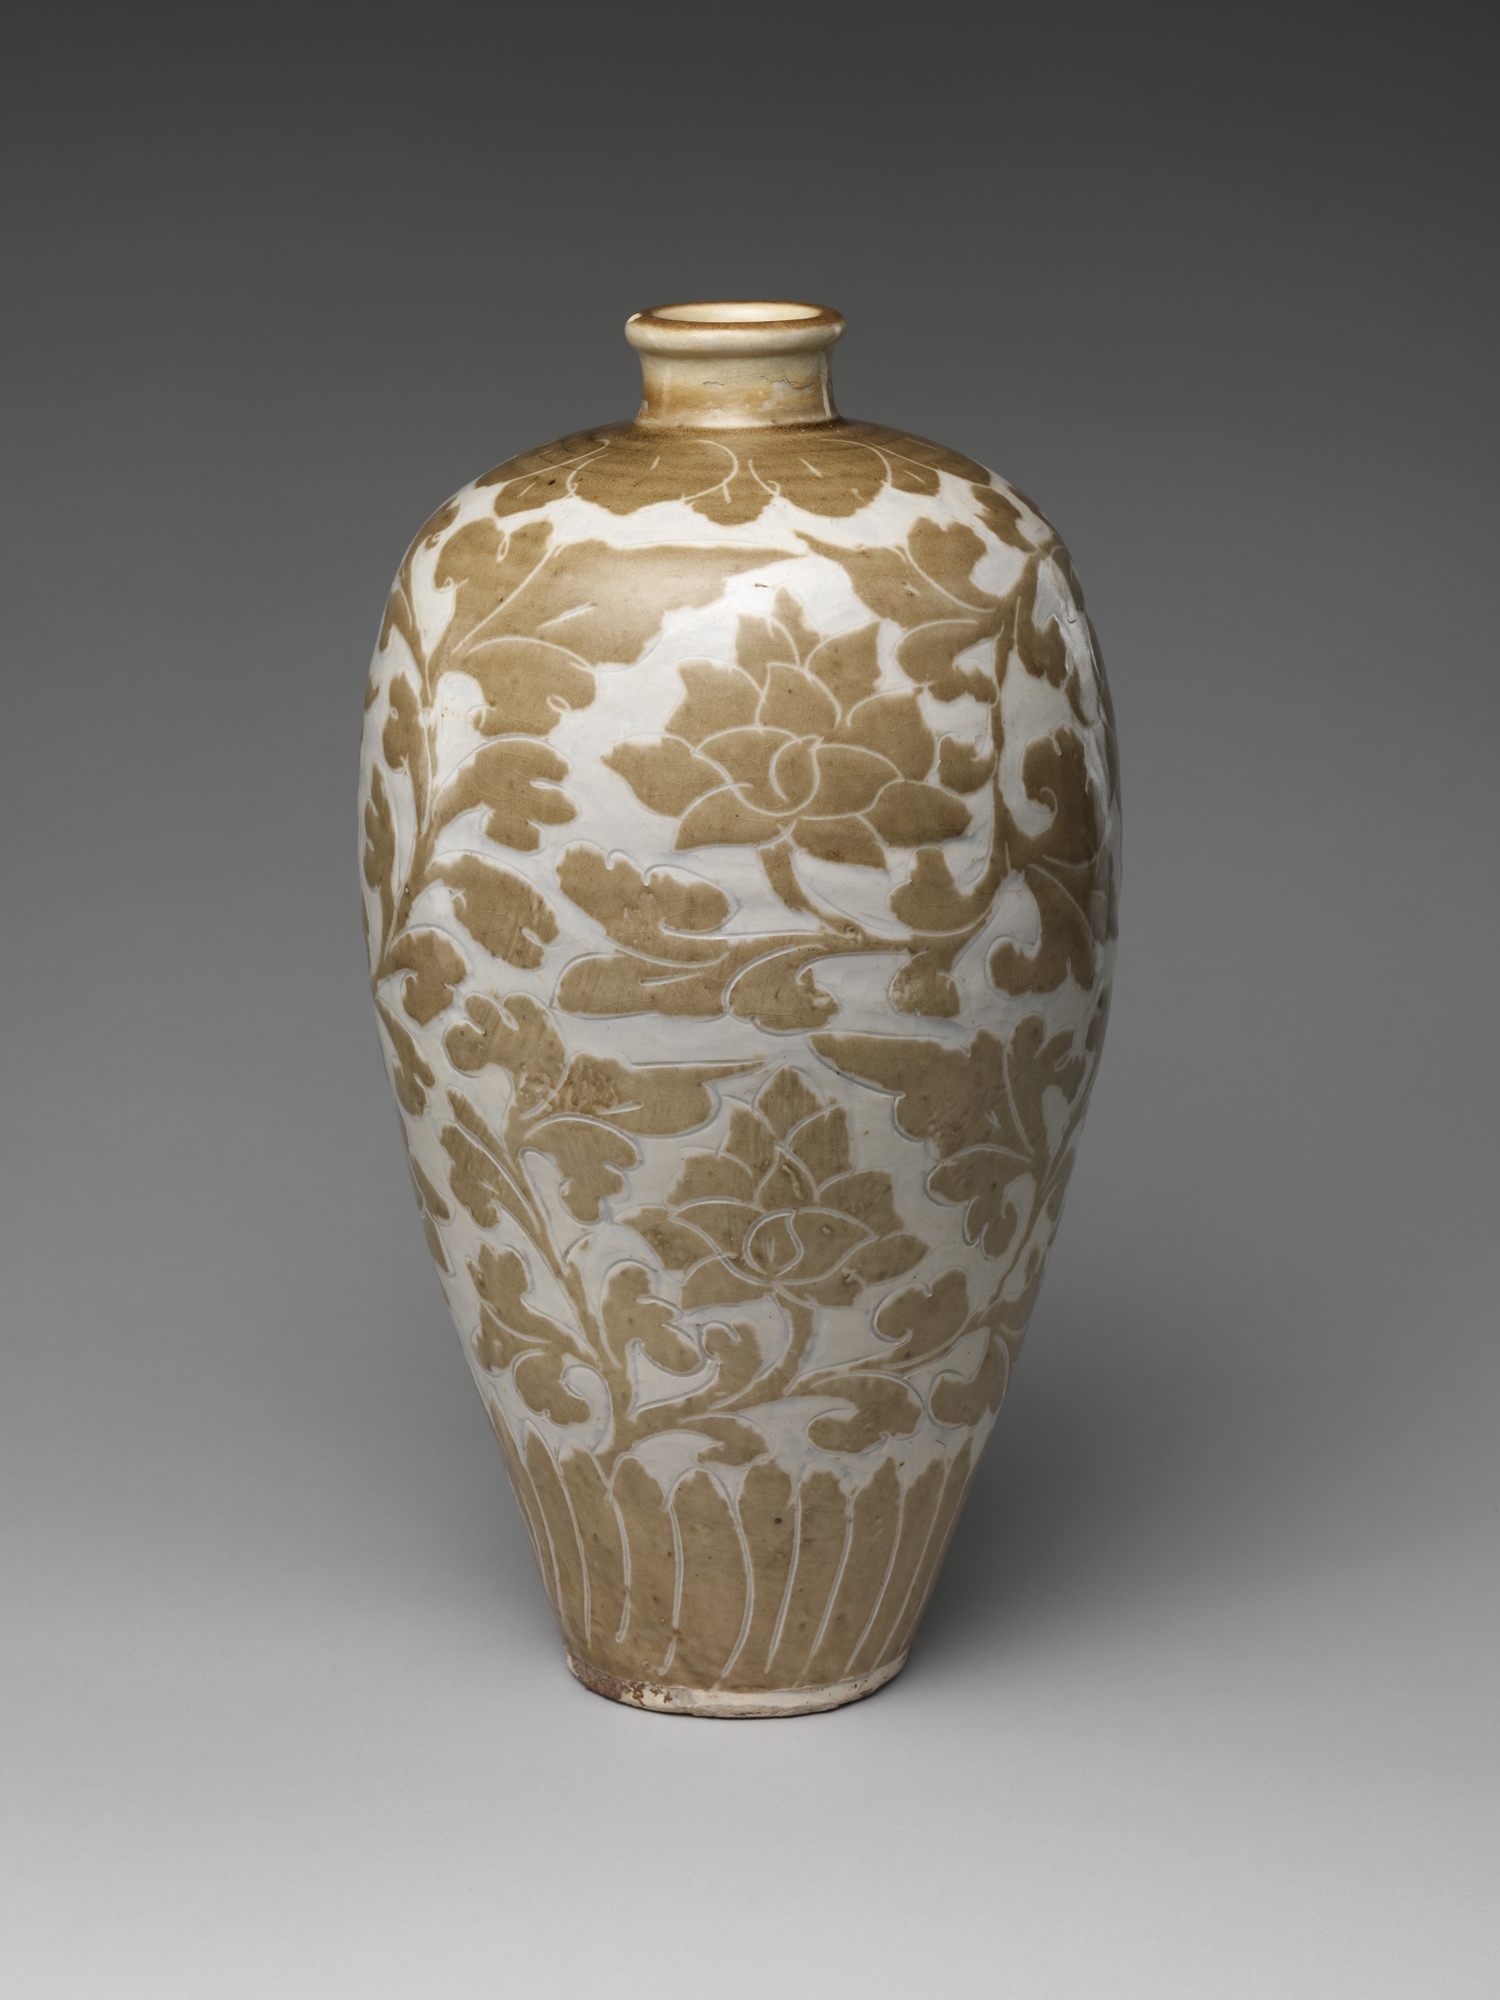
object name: vase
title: Vase with Peony Scroll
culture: chinese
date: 1101-1200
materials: glaze, stoneware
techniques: cutting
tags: peonies